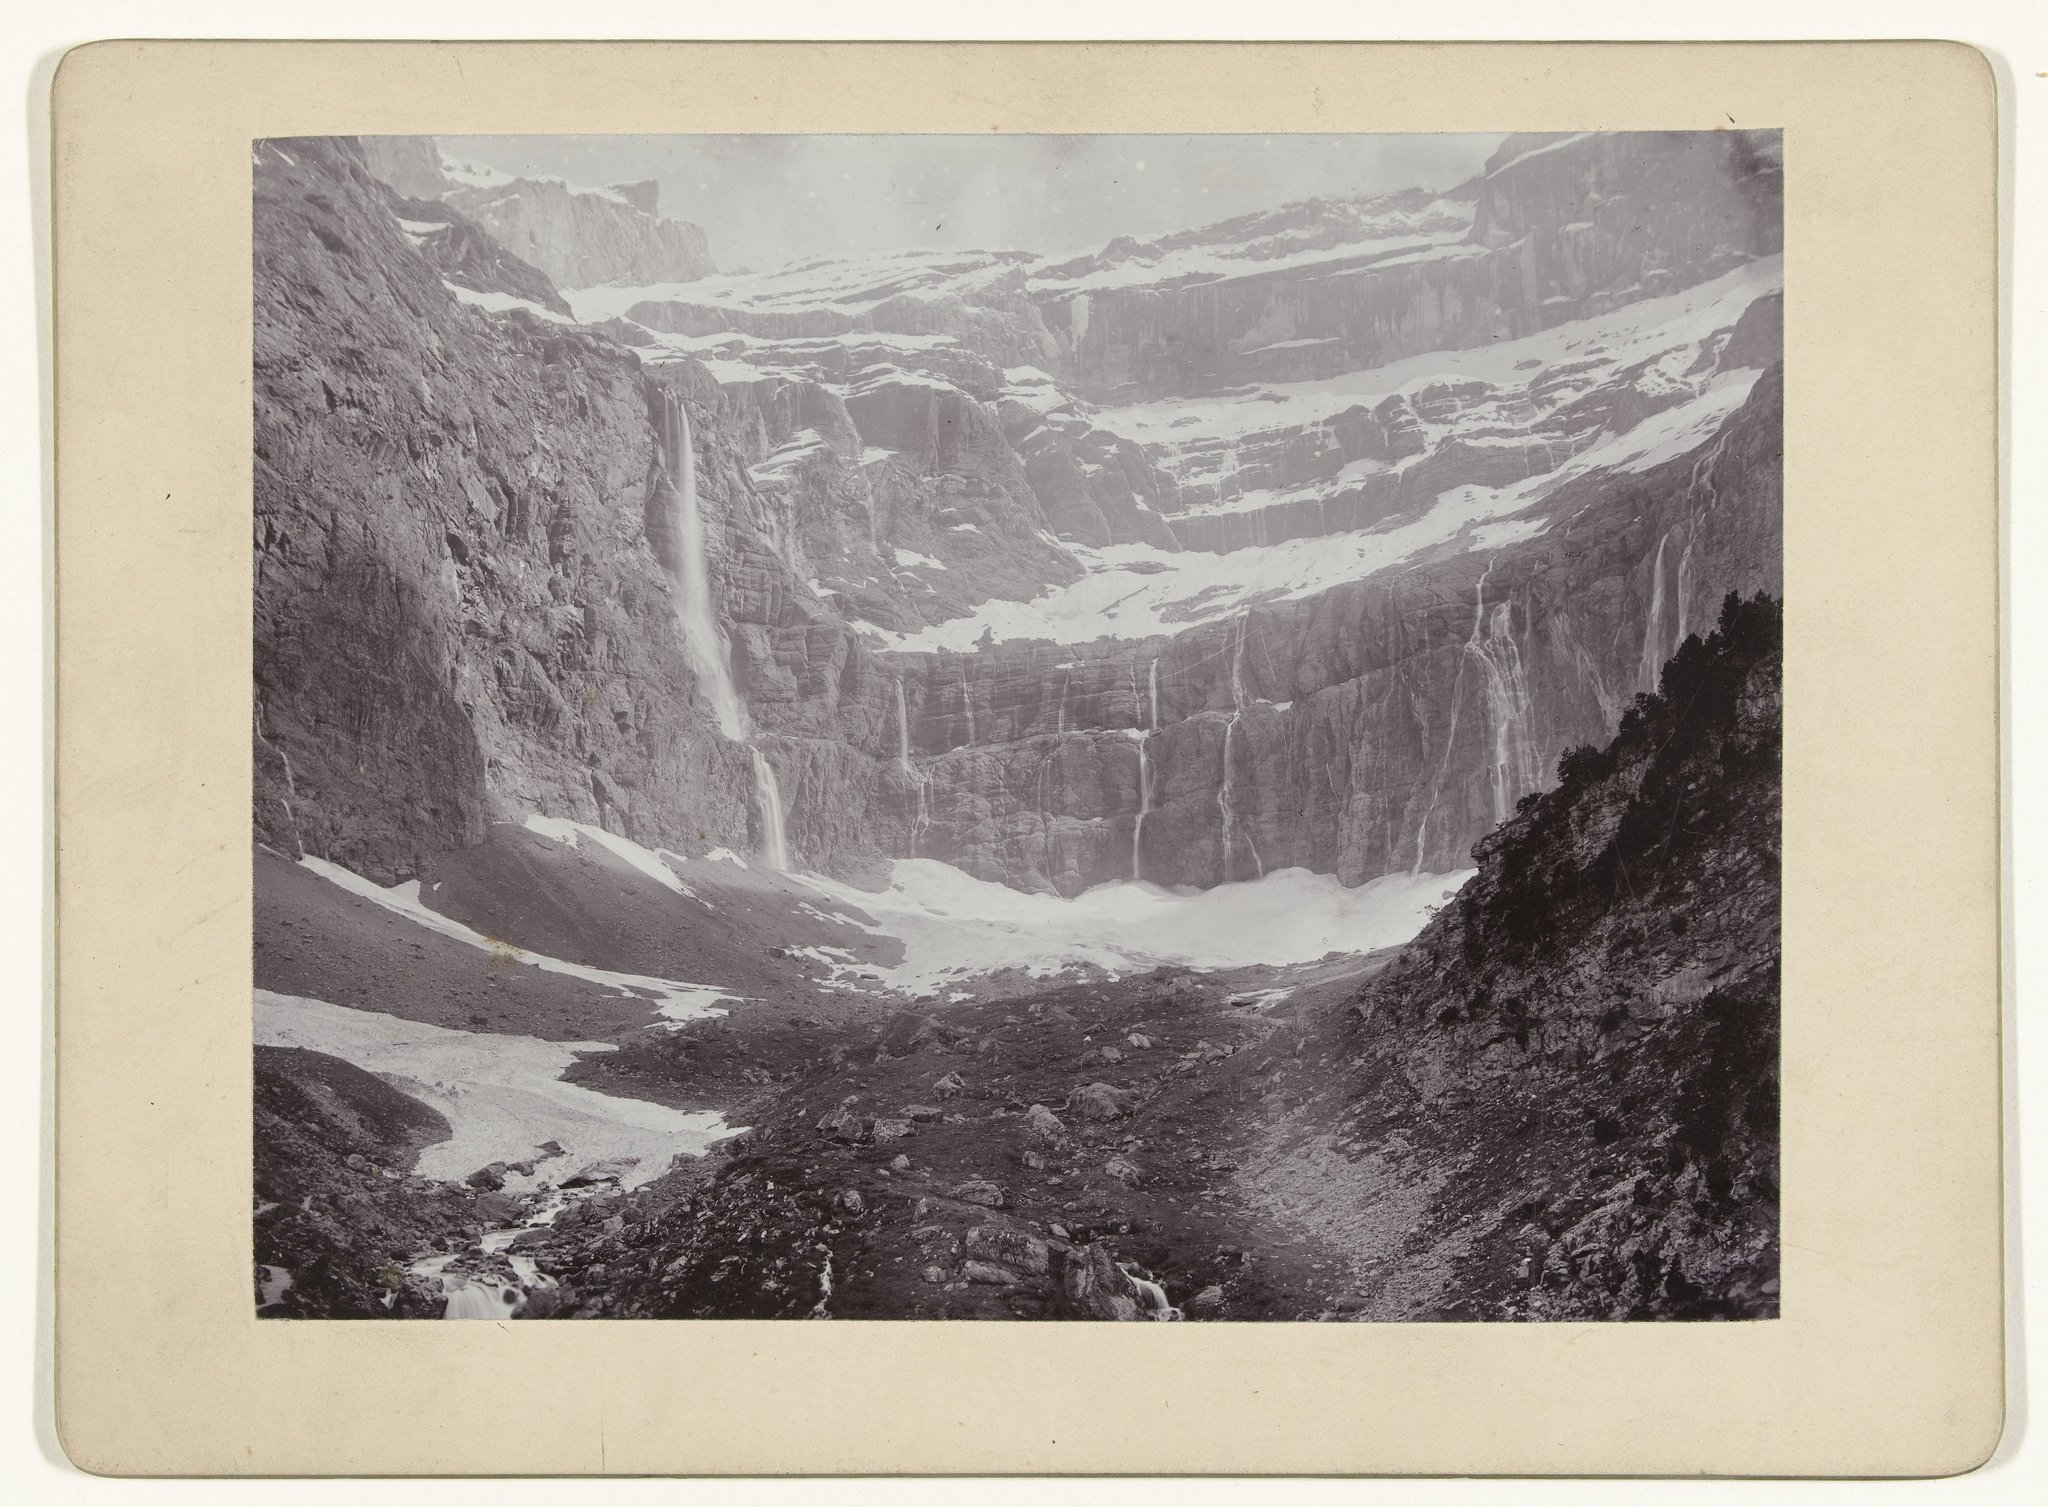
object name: photograph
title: Besneeuwd berglandschap, Cirque de Gavarnie, Pyreneeën, Frankrijk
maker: henry pauw van wieldrecht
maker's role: fotograaf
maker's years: 1863-1912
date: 1902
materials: cardboard, photographic support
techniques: gelatin silver print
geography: france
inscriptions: annotation: ‘No 2245. / 1902.’